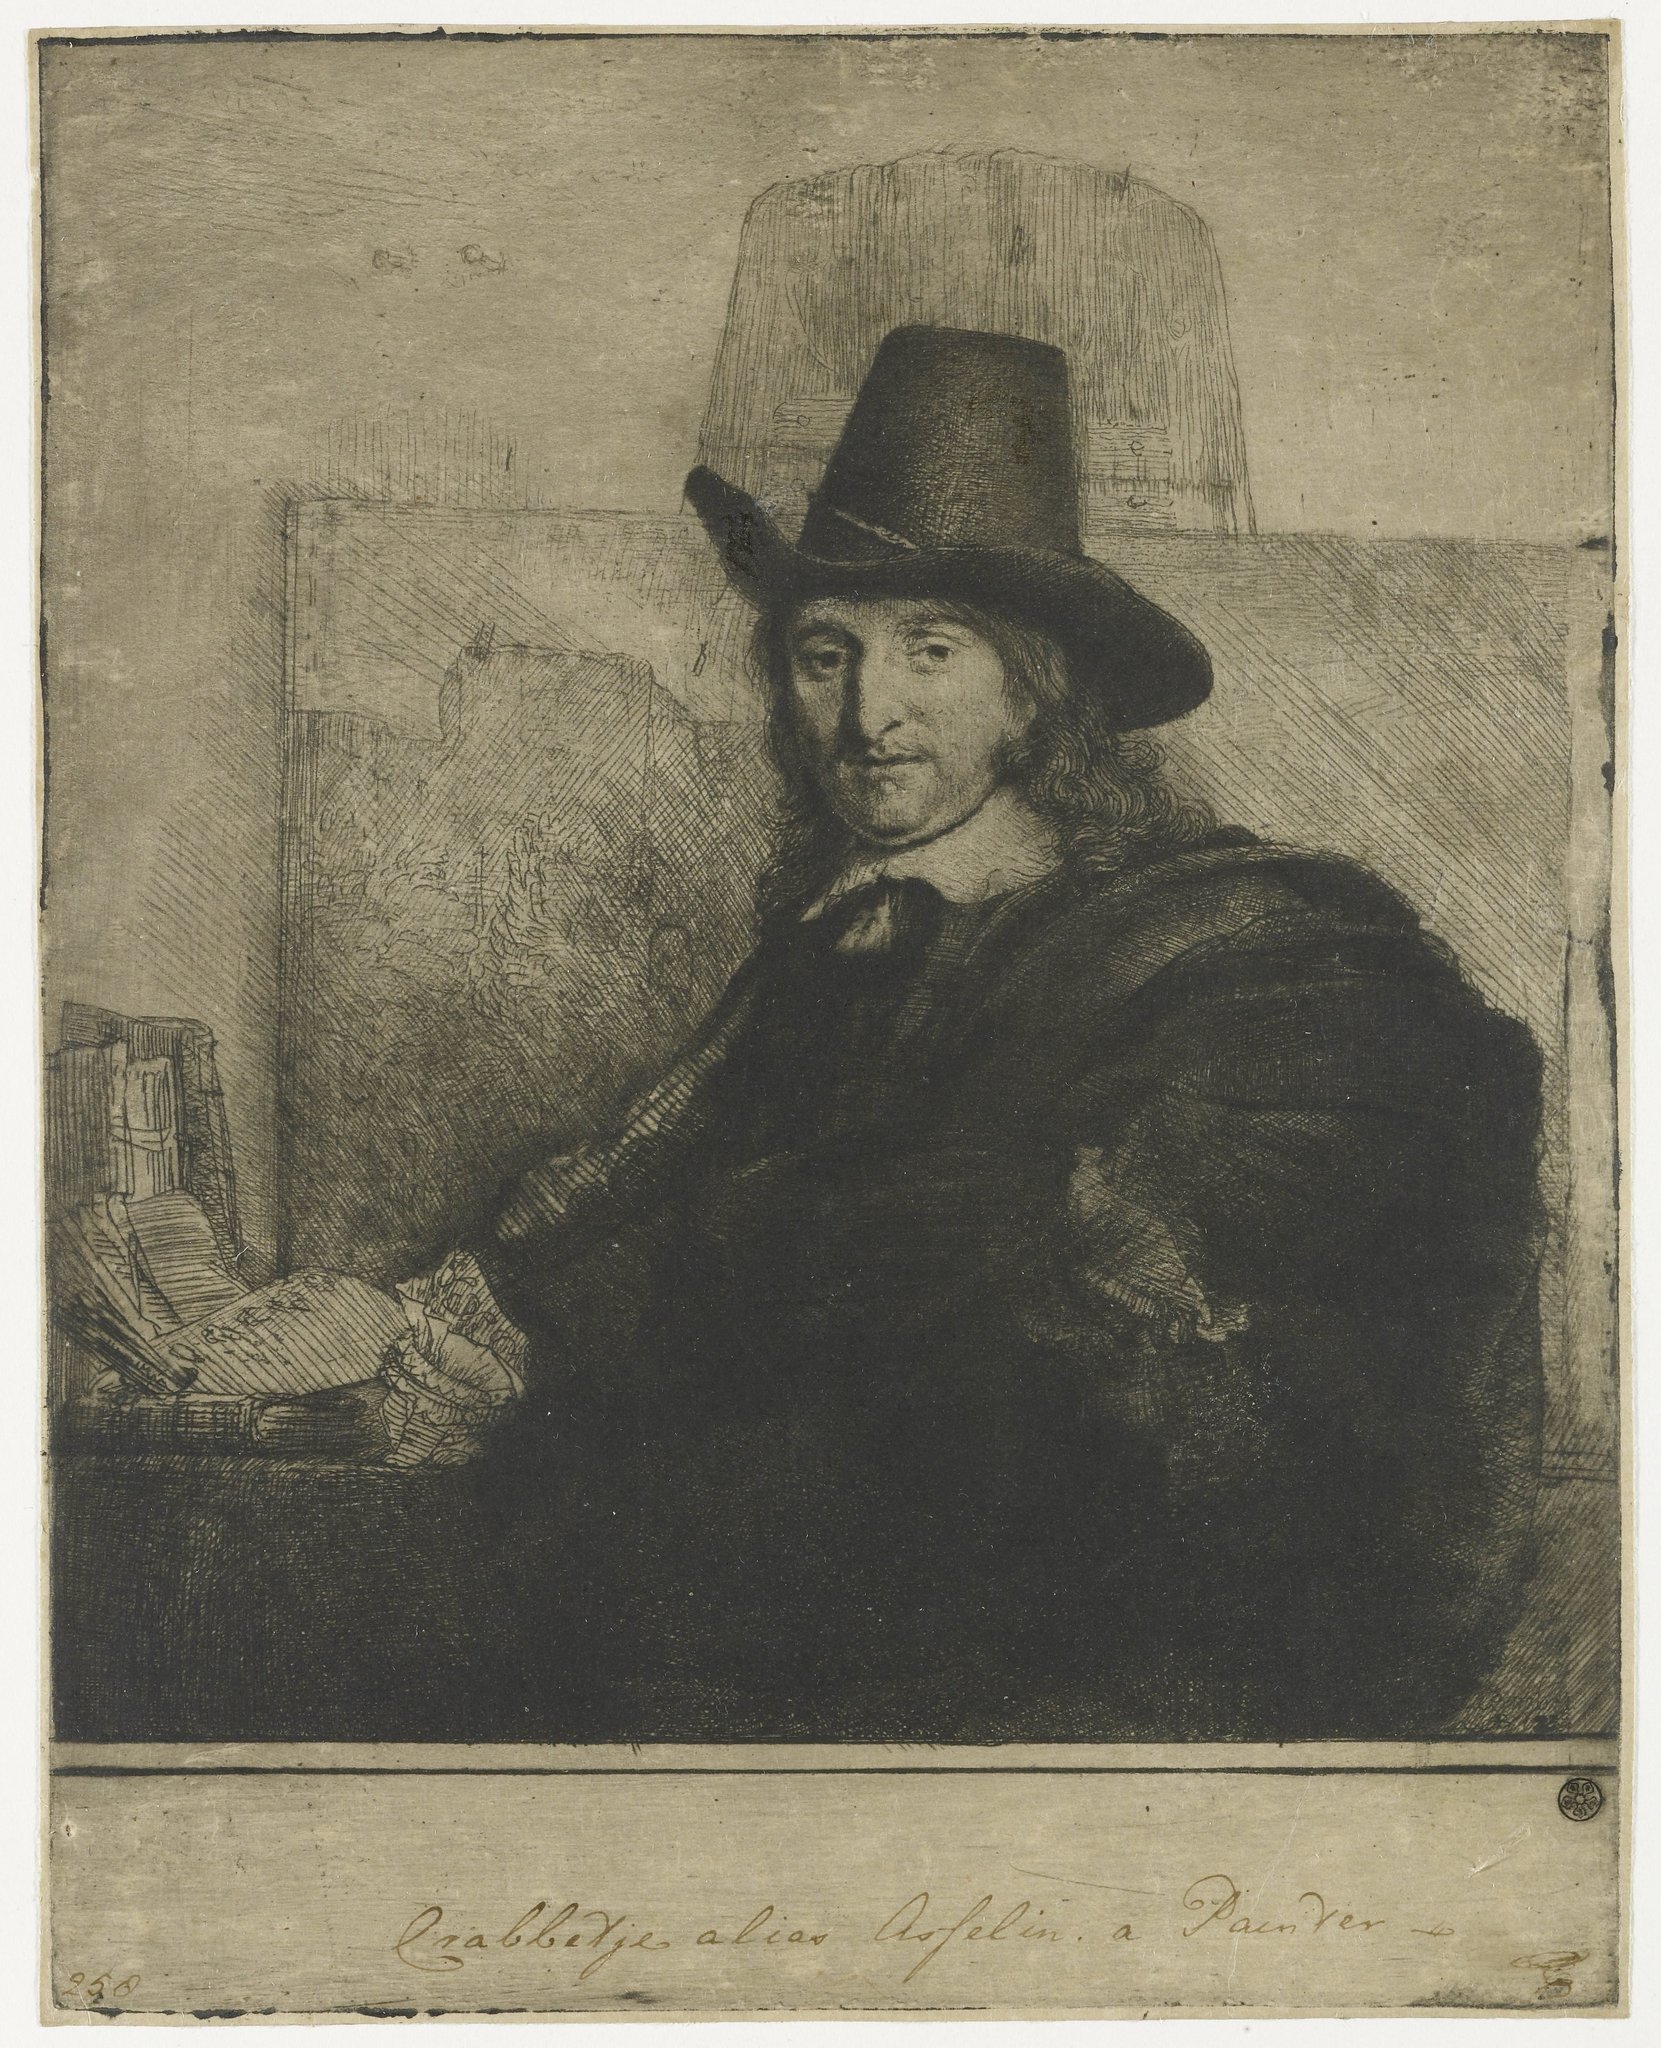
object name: print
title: Jan Asselijn (‘Krabbetje’)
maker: rembrandt van rijn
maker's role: draughtsman, painter, print maker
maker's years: 1606-1669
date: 1647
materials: paper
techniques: drypoint, etching, intaglio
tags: amsterdam, draughtsman, jan asselijn, portrait, self-portrait of painter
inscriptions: collector's mark: Lugt 2173, collector's mark: Lugt 2775, inscription: Lugt 258, collector's mark: 240, inscription: ‘Crabbetje alias Asselin a Painter’ handschrift van P. Remy, signature and date: ‘Rembr / f 16’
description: With his left arm akimbo and a self-assured gaze, the painter Jan Asselijn poses before one of his canvasses. He specialized in Italianate landscapes and city views, and with the books on the table at the left he is telling us that he was also well-read. This portrait is one of the first etchings that Rembrandt printed on costly Japanese paper.